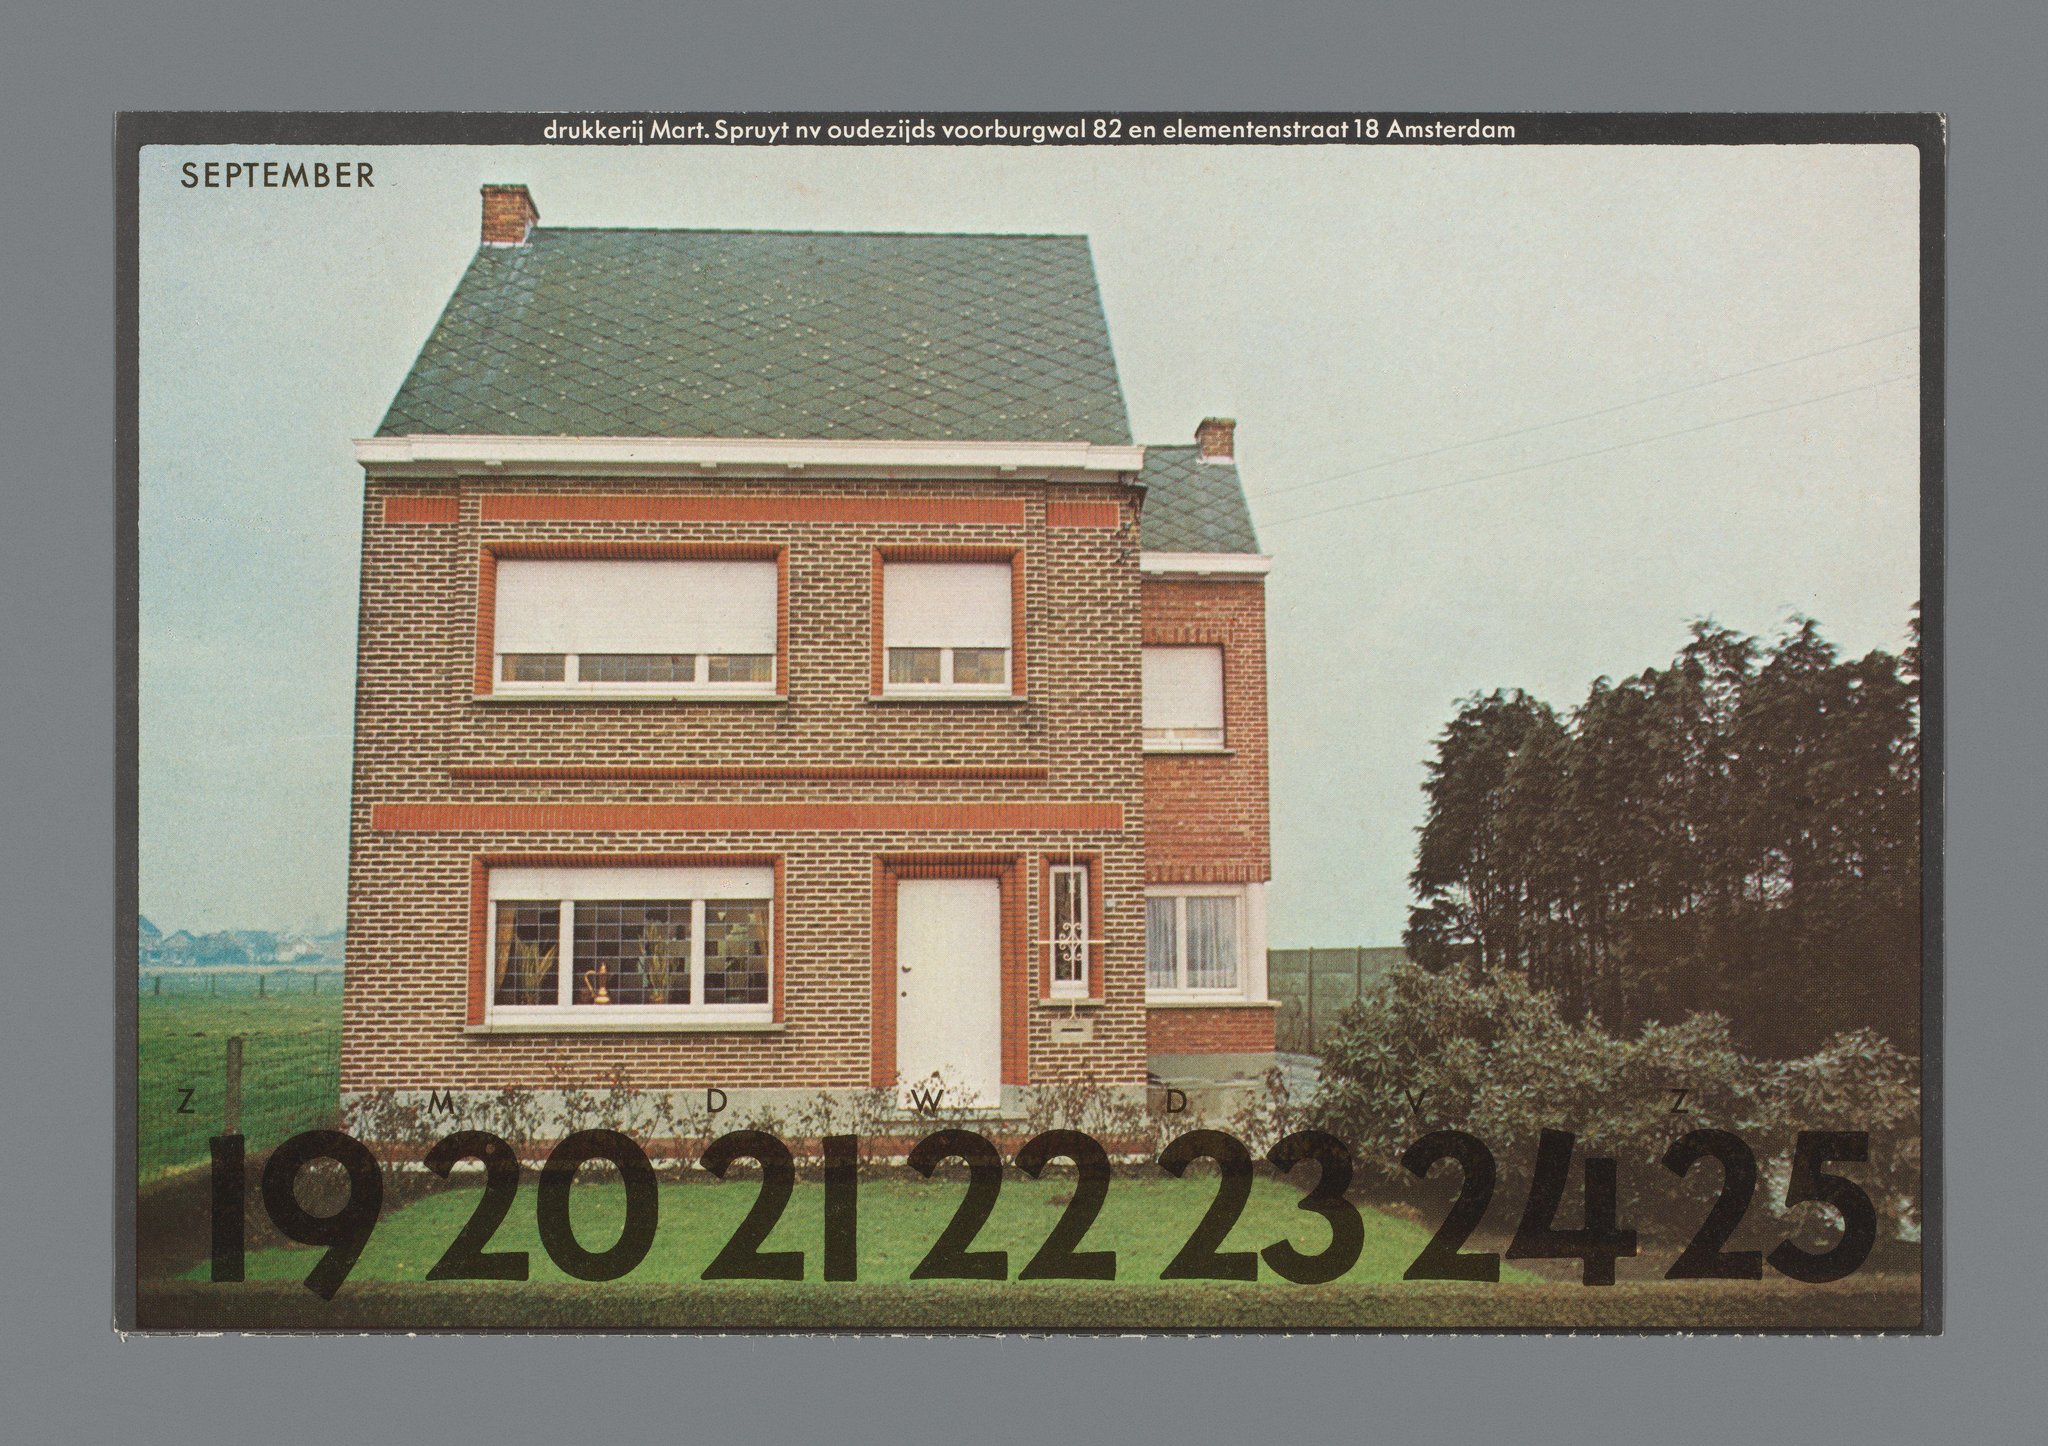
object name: photograph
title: België. Huizen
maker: Anonymous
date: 1900-1950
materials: paper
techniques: offset printed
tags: belgium